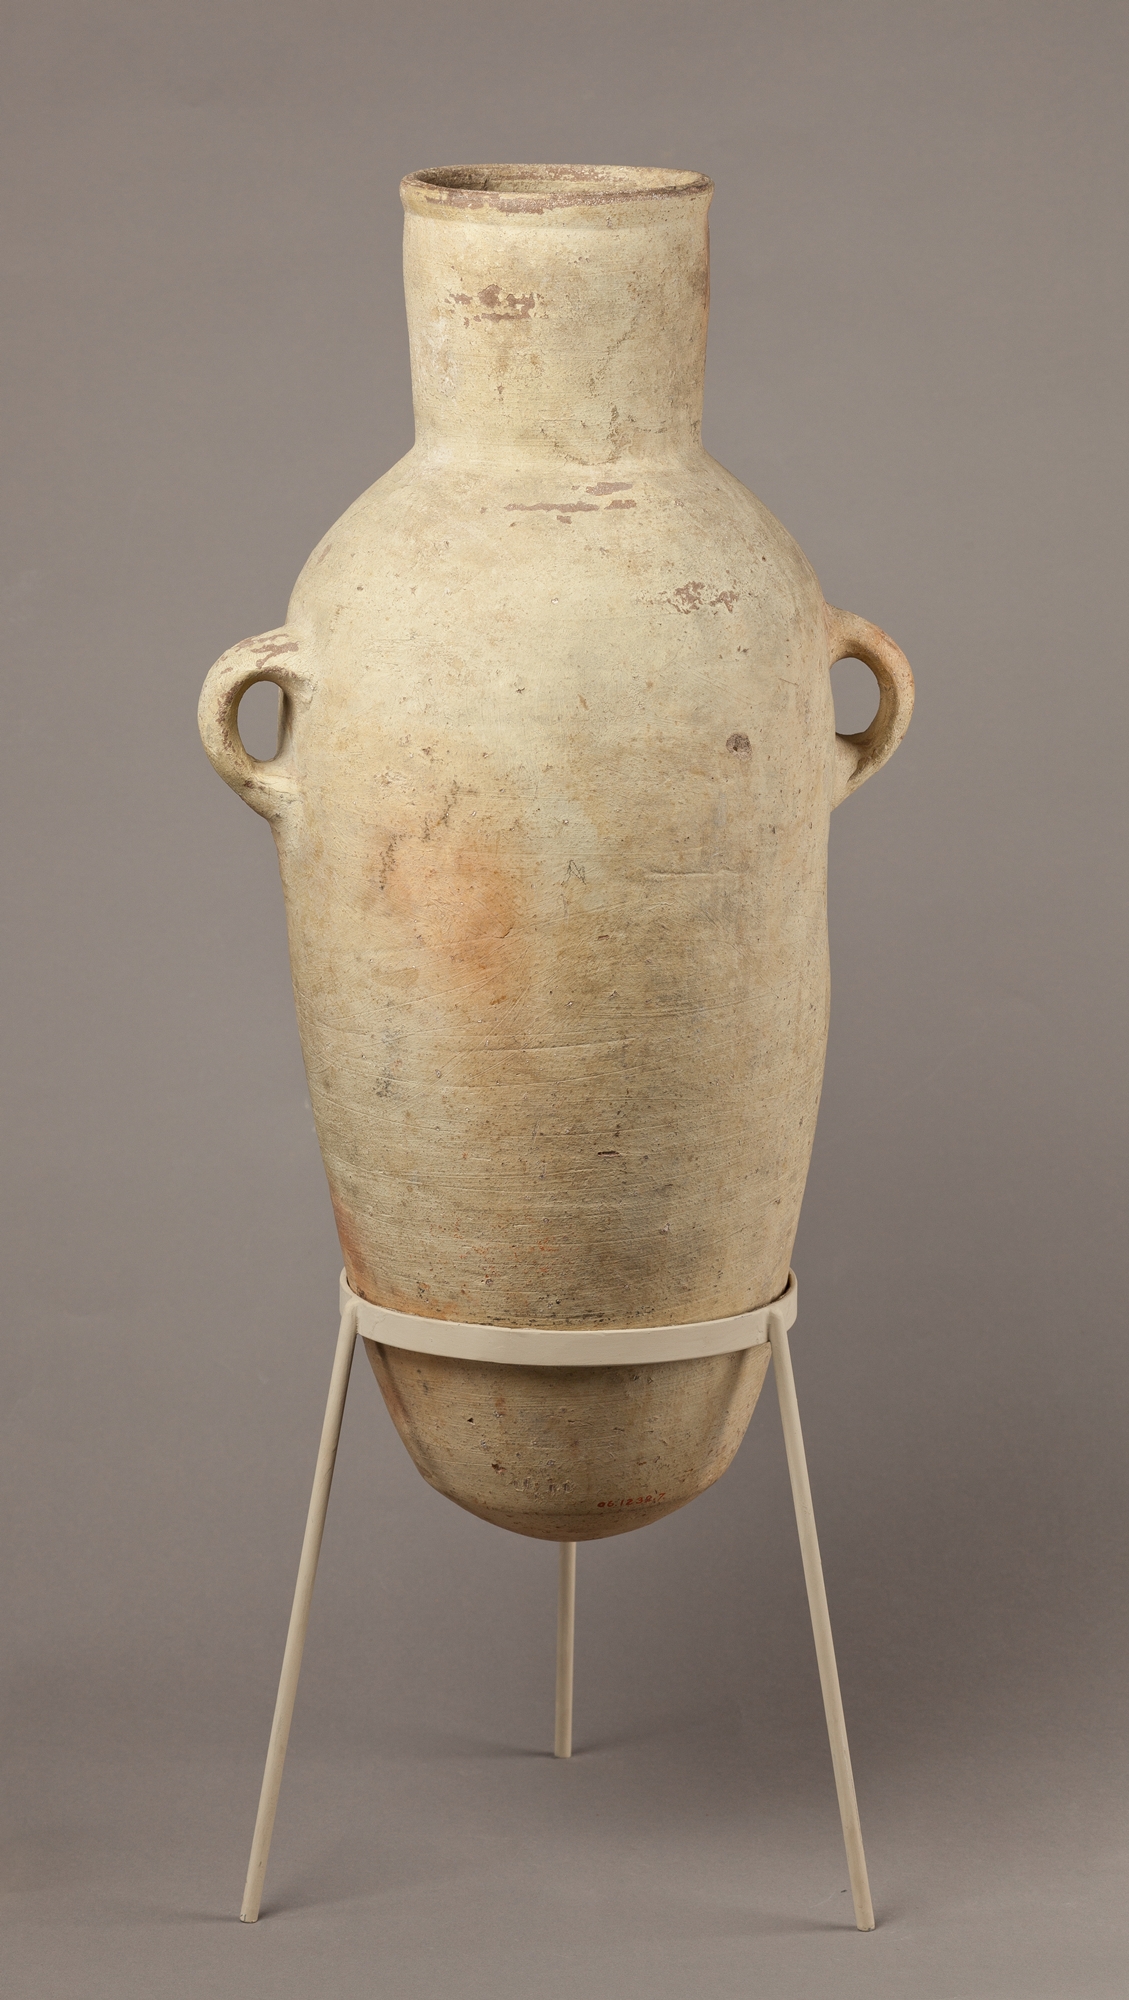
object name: jar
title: Jar with handles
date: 1550-1295 BCE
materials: pottery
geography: egypt